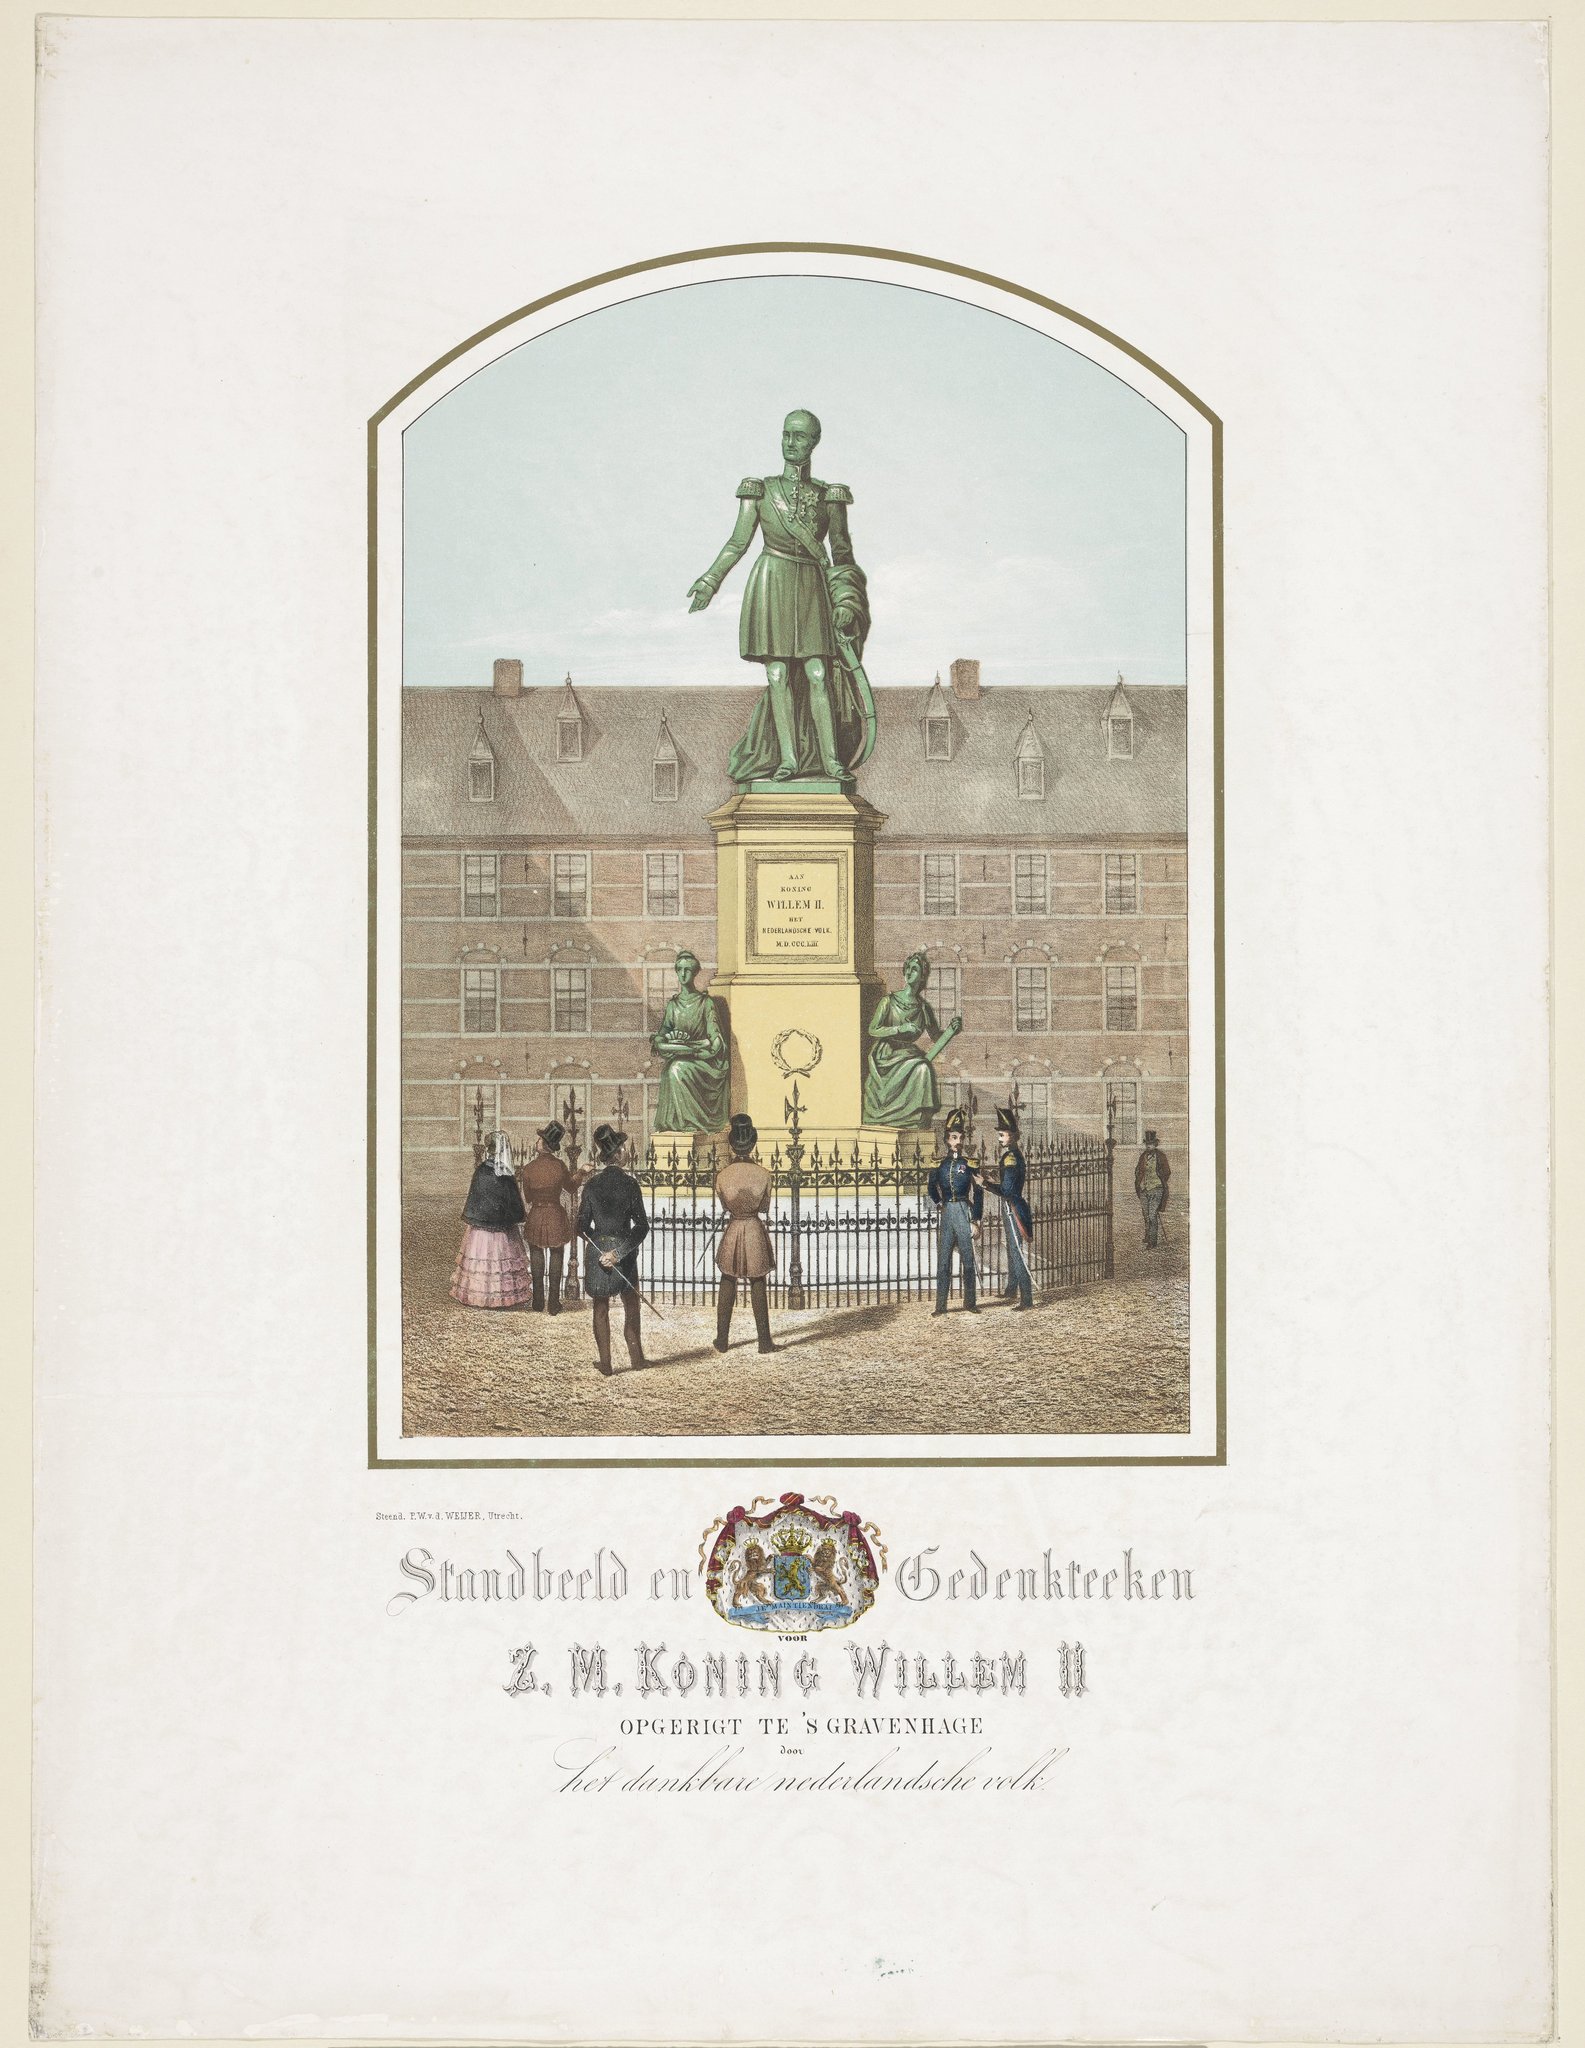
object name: print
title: Standbeeld van Willem II, koning der Nederlanden, op het Buitenhof te Den Haag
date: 1853-1871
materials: paper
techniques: lithograph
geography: utrecht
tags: the hague, william ii of the netherlands, monument, statue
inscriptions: collector's mark: Lugt 963, collector's mark: Lugt 2165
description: Standbeeld van Willem II door Eduard François Georges op het Buitenhof te Den Haag. Op straat staan figuren. Midden onder zijn wapen met een kroon en twee leeuwen. Daaronder op een banderol zijn geslachtsspreuk. In de ondermarge zes regels Nederlandse tekst.